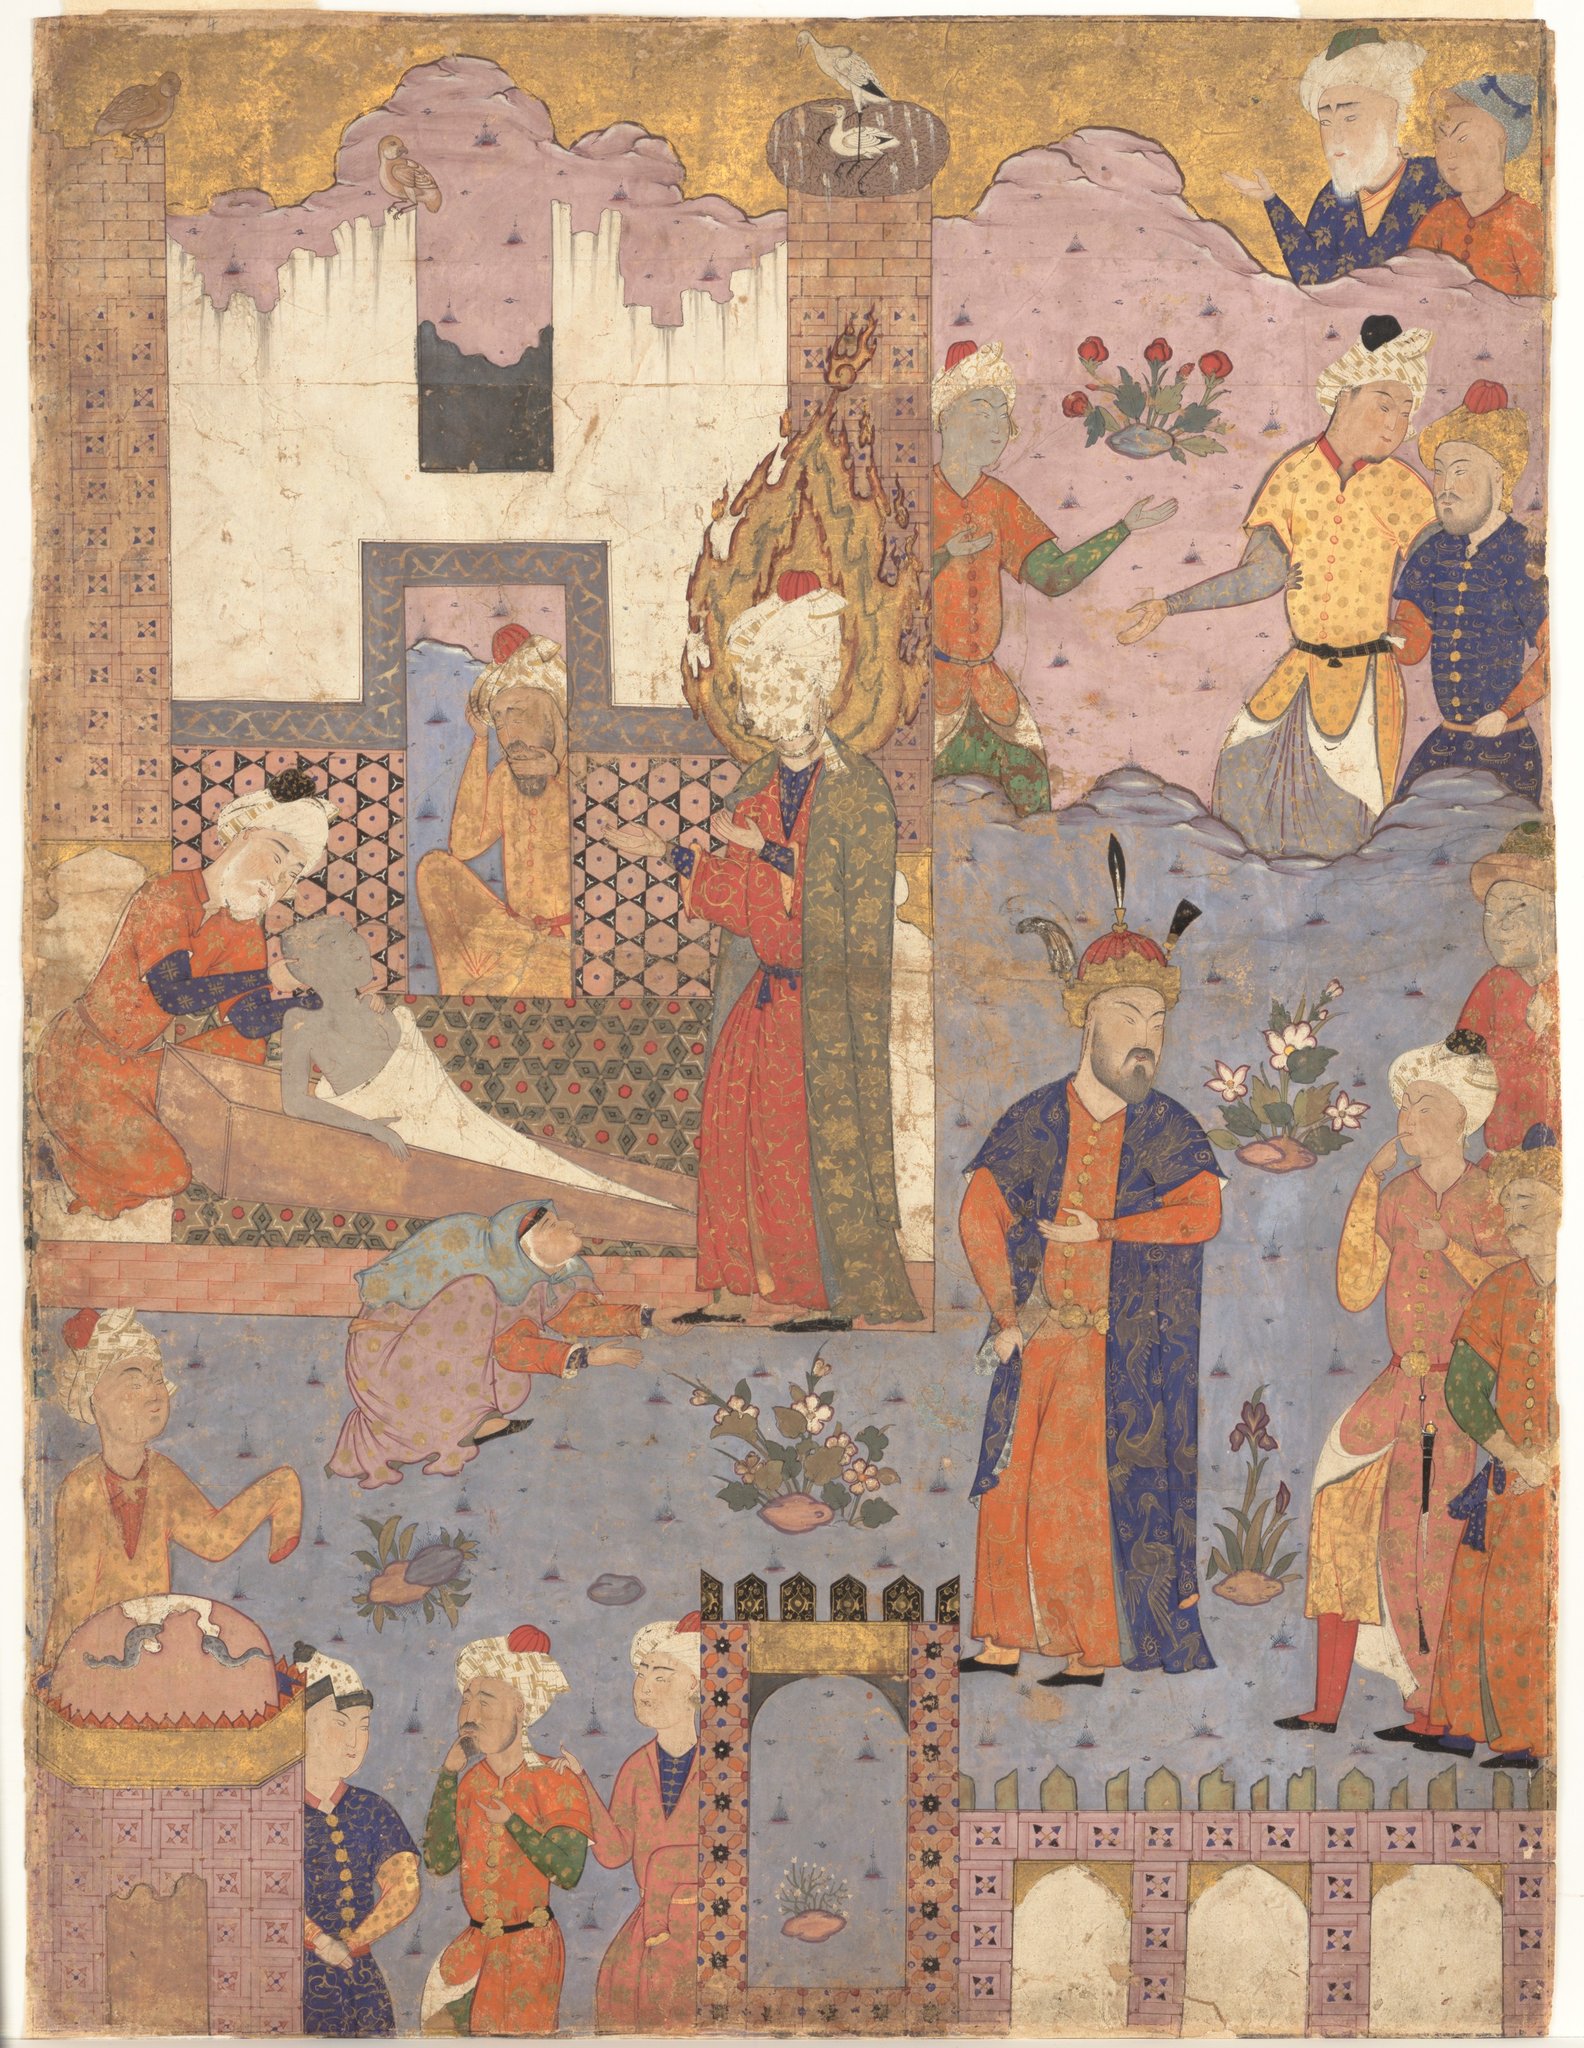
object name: folio from an illustrated manuscript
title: "Muhammad Revives the Sick Boy", Folio from a Falnama (Book of Omens) of Ja'far al-Sadiq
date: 1550-1559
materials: gold, ink, paper, watercolor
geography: iran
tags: illness,boys,men,women